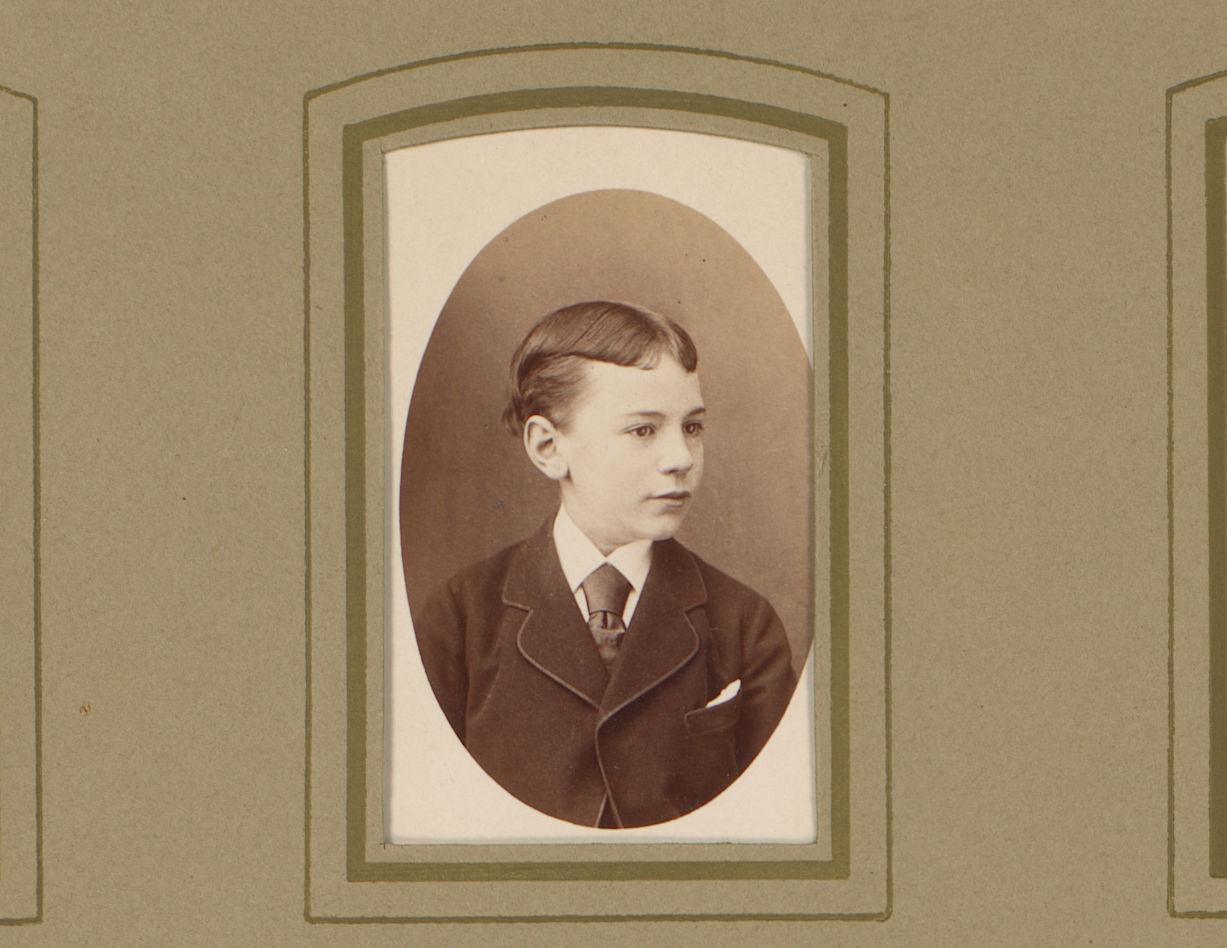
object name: photograph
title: Portret van een jongen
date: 1867-1884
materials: cardboard, photographic support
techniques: albumen print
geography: netherlands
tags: boy (child between toddler and youth), historical persons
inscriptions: number: ‘6’, inscription: ‘Photographisch Artistisch Atelier/ van/ Wegner & Mottu/ Amsterdam/ Rokin over de Bank/ 138./ Utrecht/ Hamburgerstraat/ F. 237./ Het cliché wordt voor verdere/ bestellingen bewaard.’